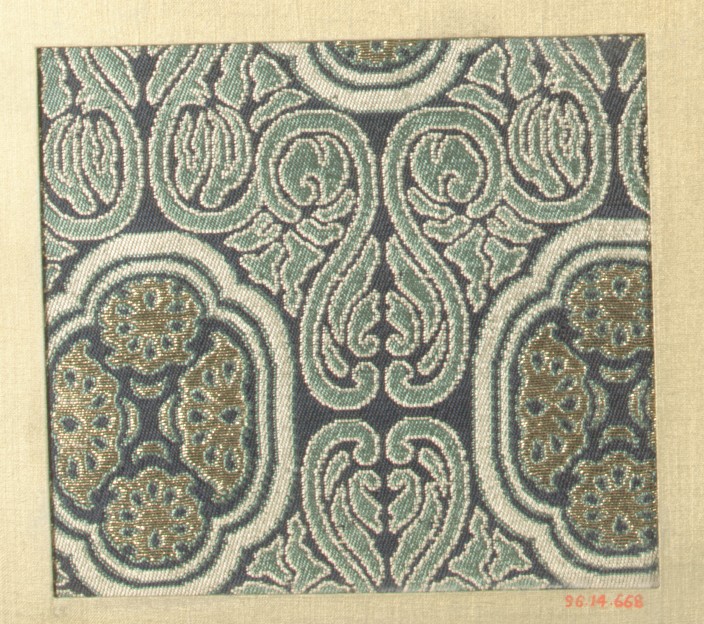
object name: piece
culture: japanese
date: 1701-1900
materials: silk